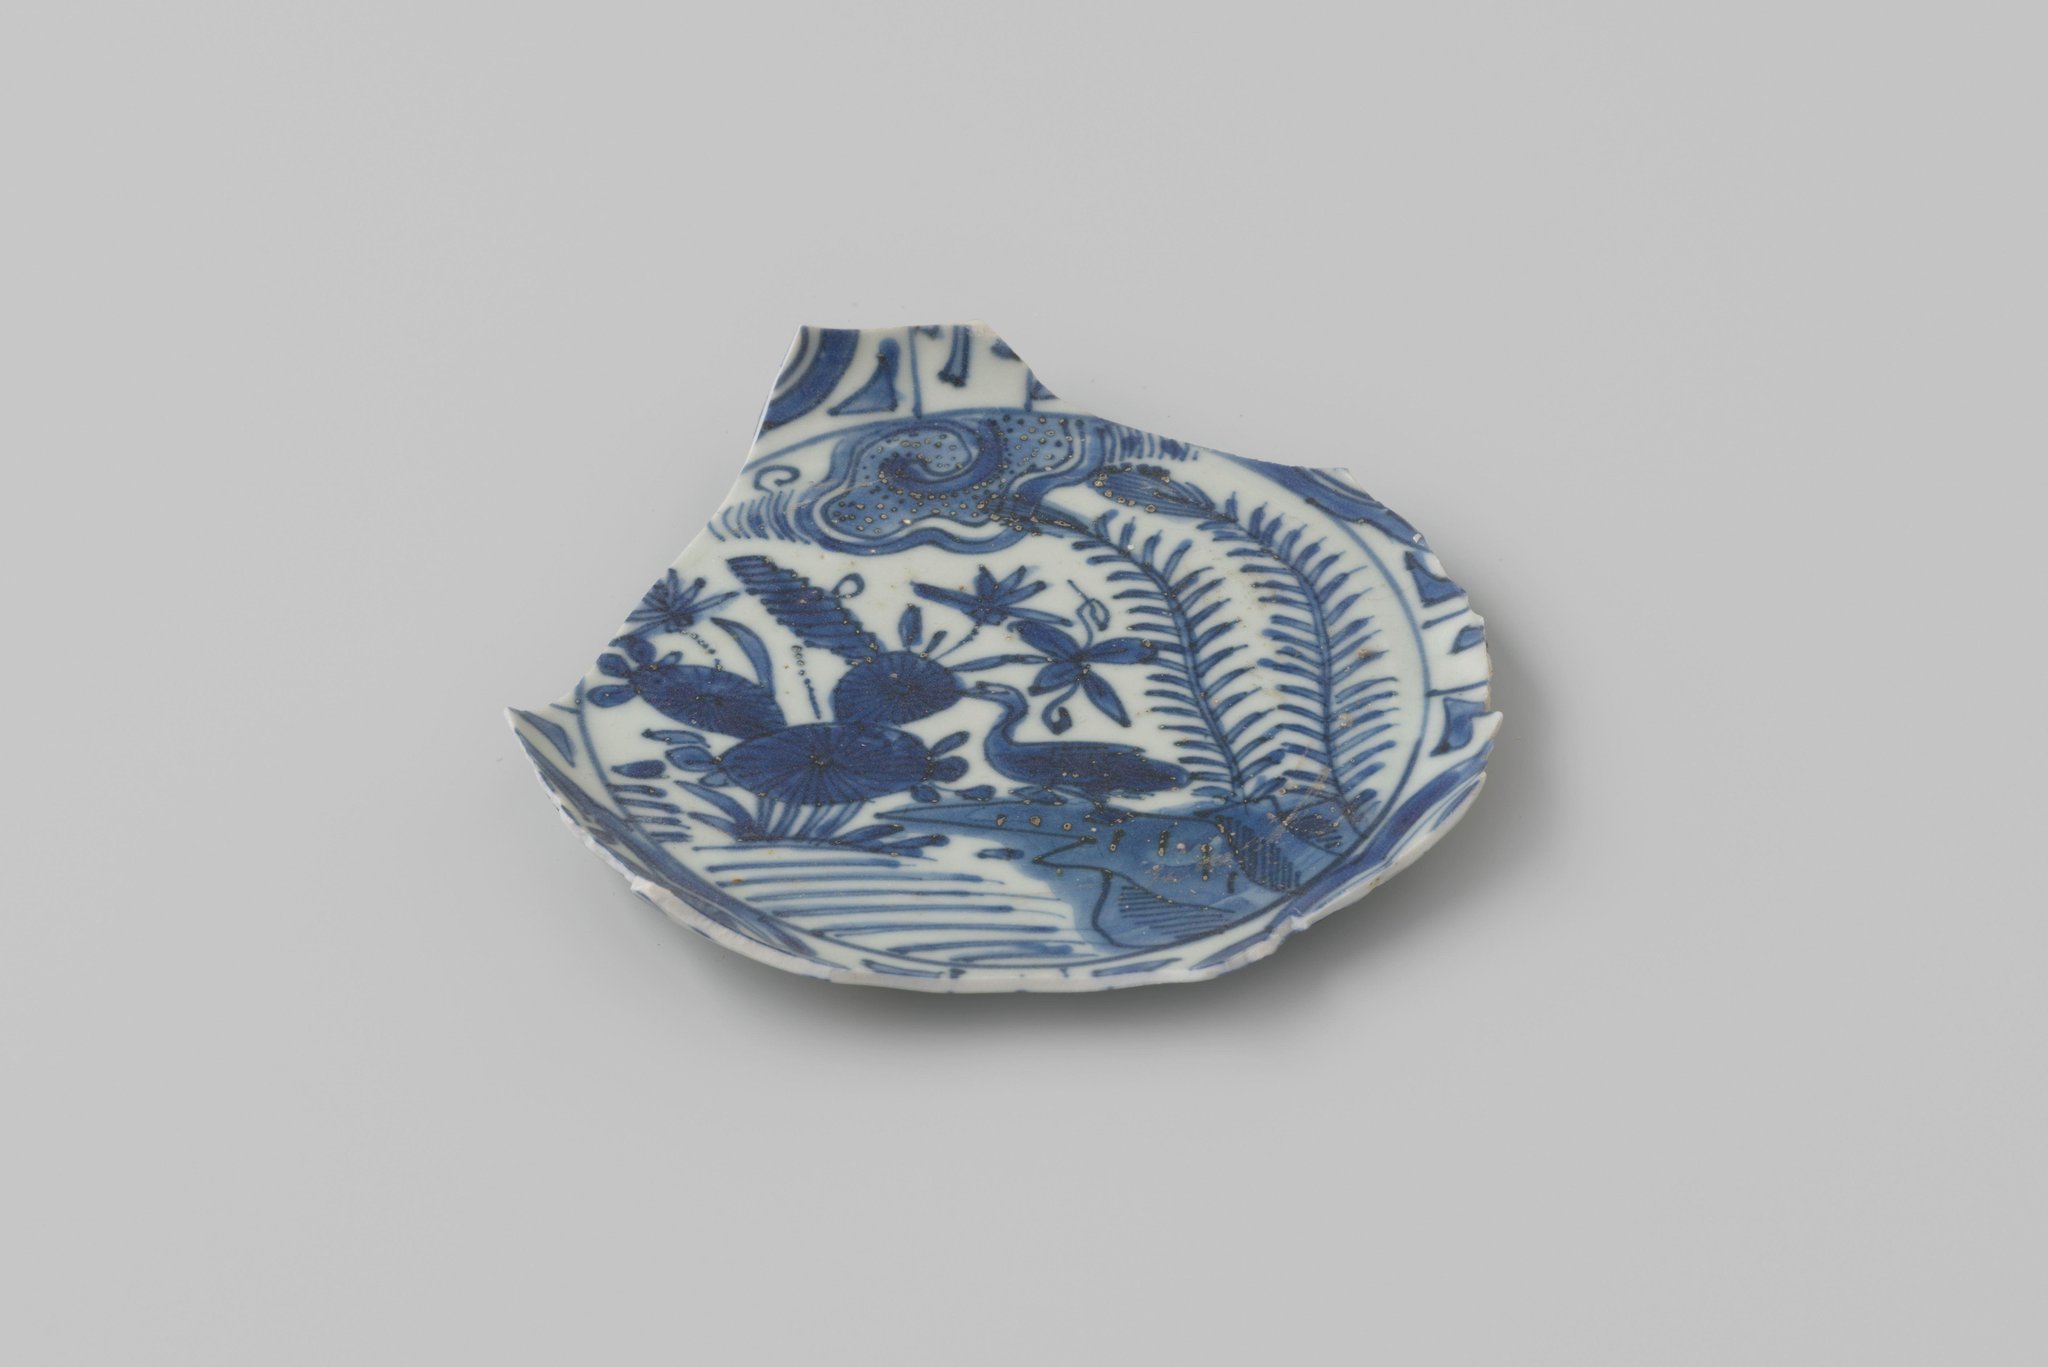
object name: sherd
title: Fragment diep bord uit V.O.C.-schip de 'Witte Leeuw'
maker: Anonymous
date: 1613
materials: bone china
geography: jingdezhen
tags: verenigde oostindische compagnie, sint-helena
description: Fragment diep bord uit V.O.C.-schip de 'Witte Leeuw'. 30% aanwezig.